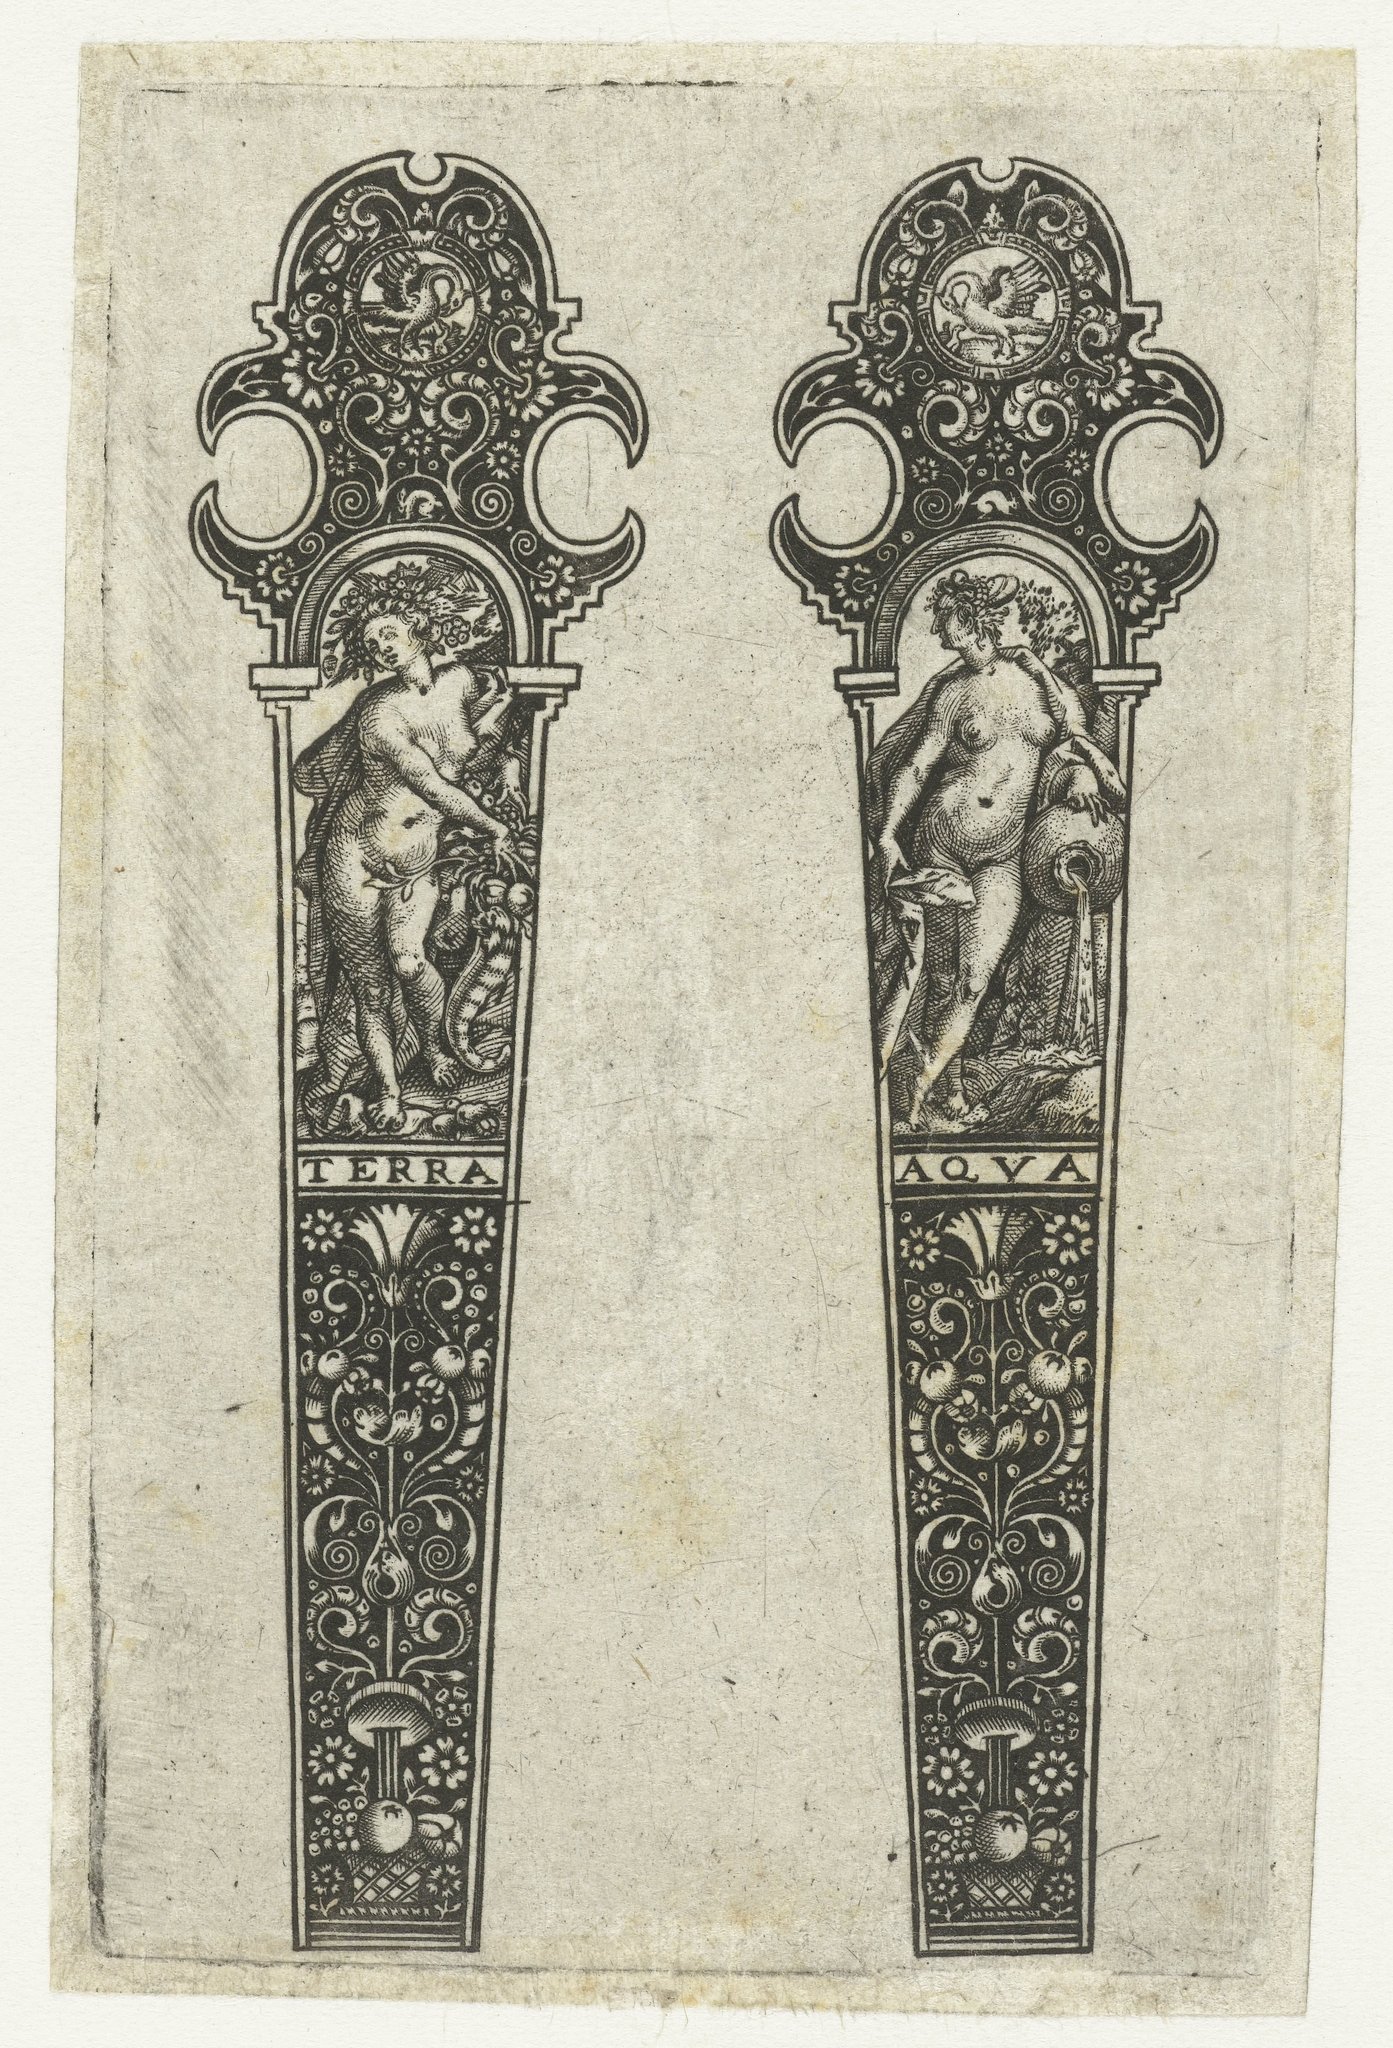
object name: print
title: Messenheften met de vier elementen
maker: Anonymous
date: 1610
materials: paper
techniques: engraving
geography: netherlands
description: De personificaties staan afgebeeld boven een kandelaber.